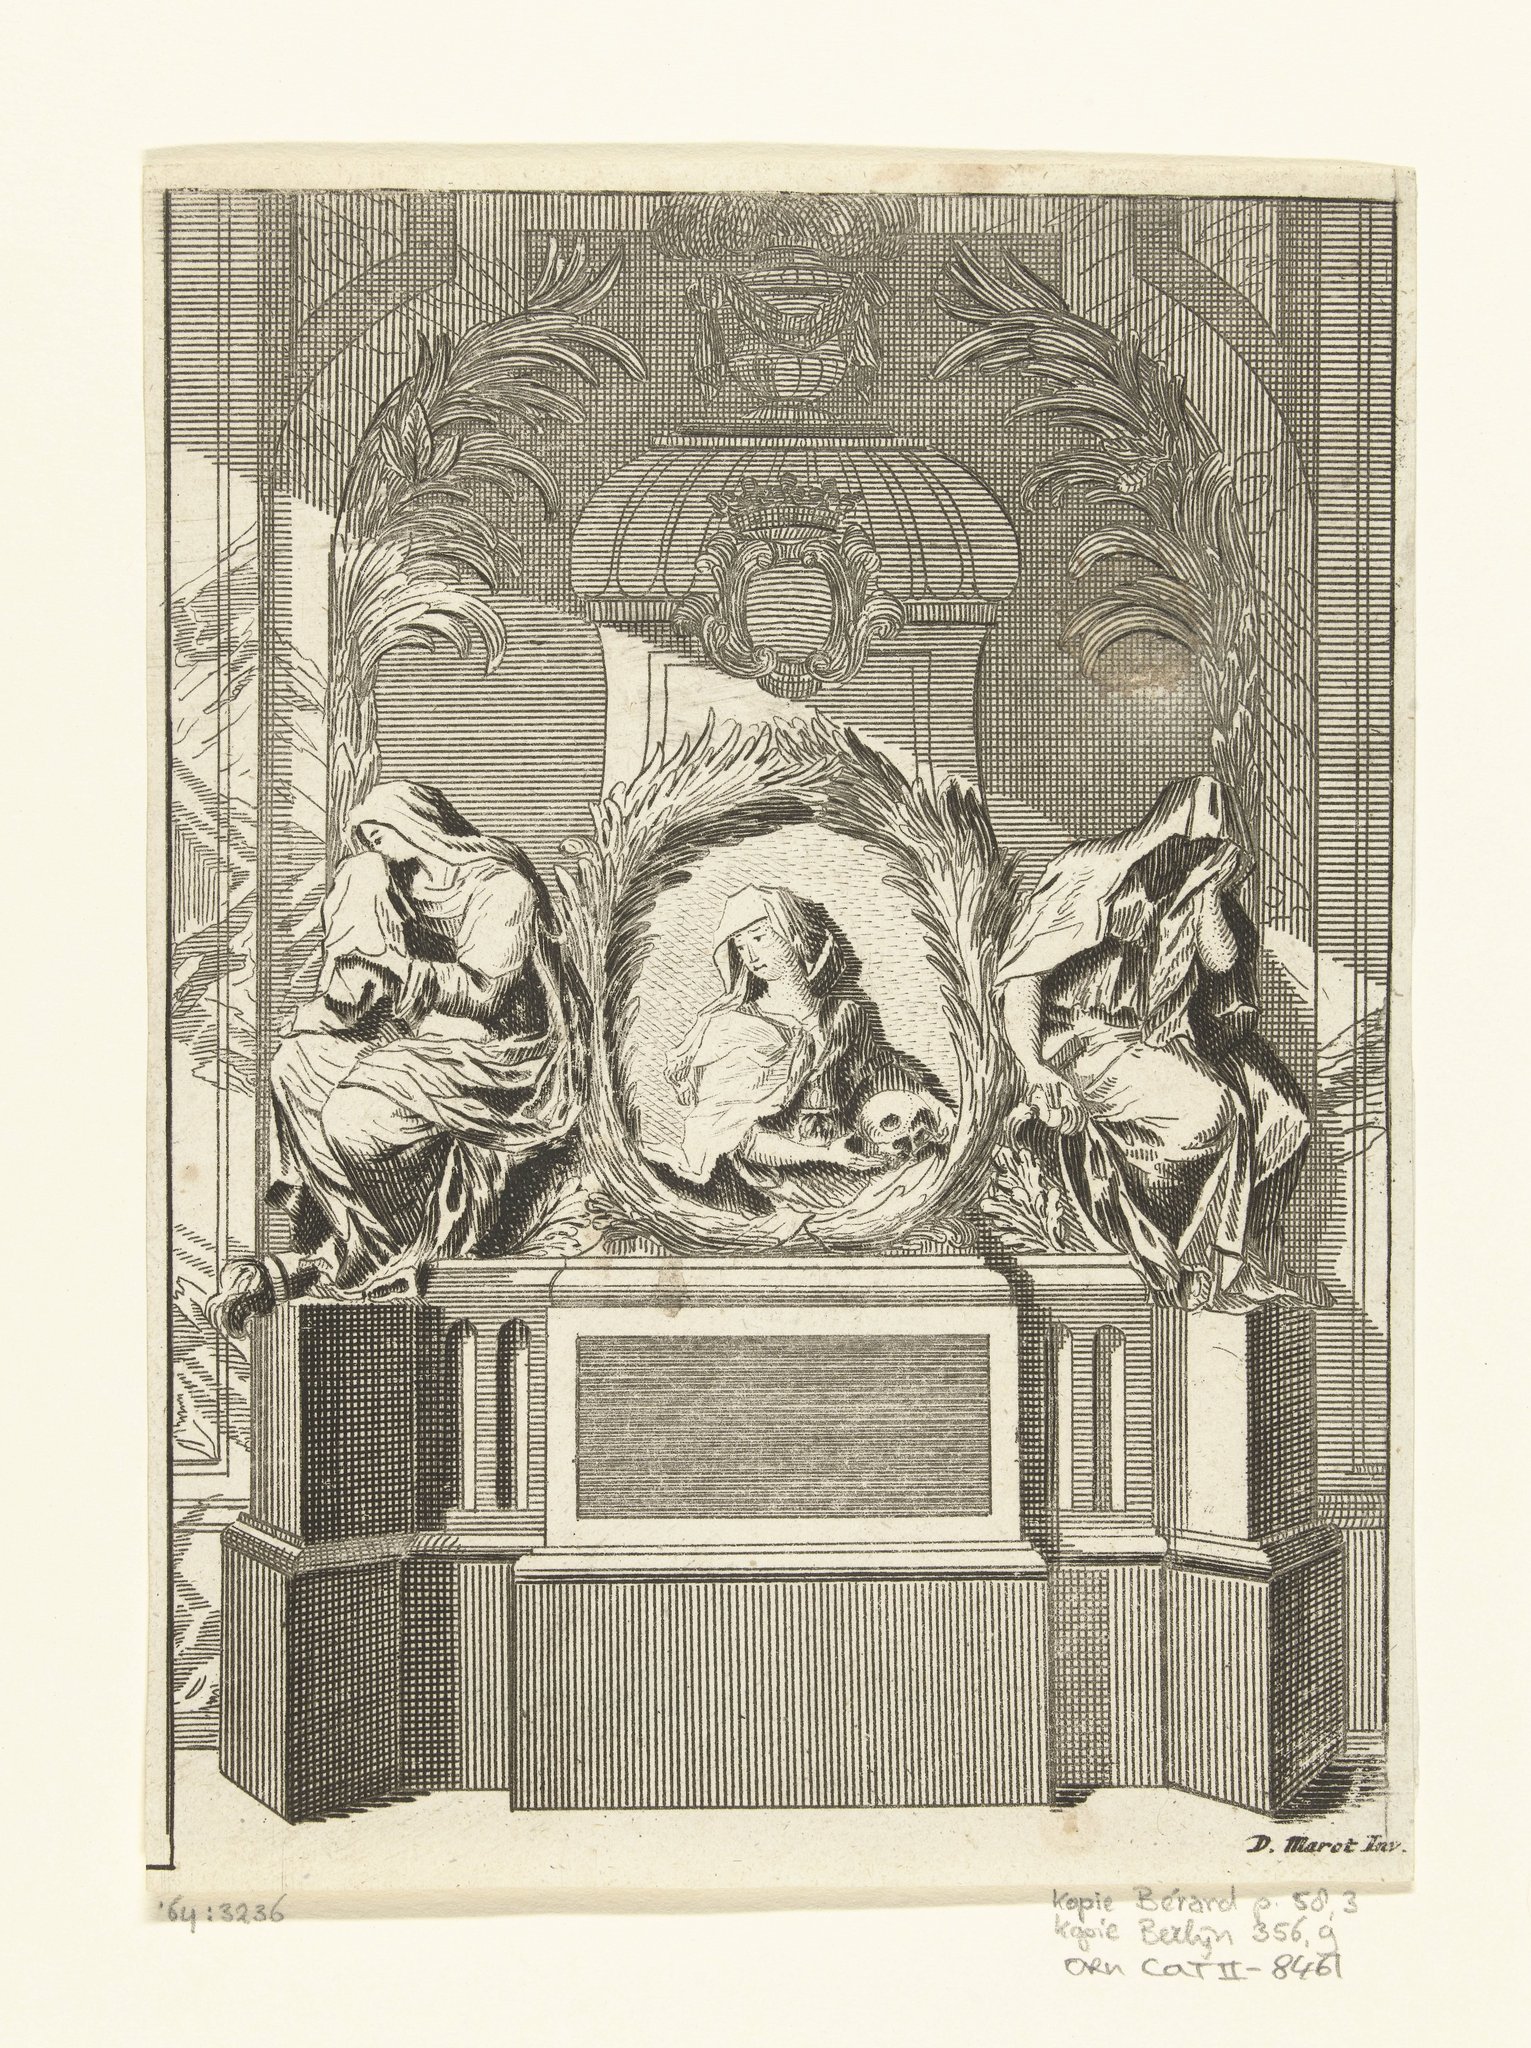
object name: print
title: Epitafen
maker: Anonymous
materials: paper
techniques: etching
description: Grafmonument met ovaal medaillon waarin een gesluierde vrouw een schedel vasthoudt. Links en rechts van het medaillon zitten rouwende vrouwen.